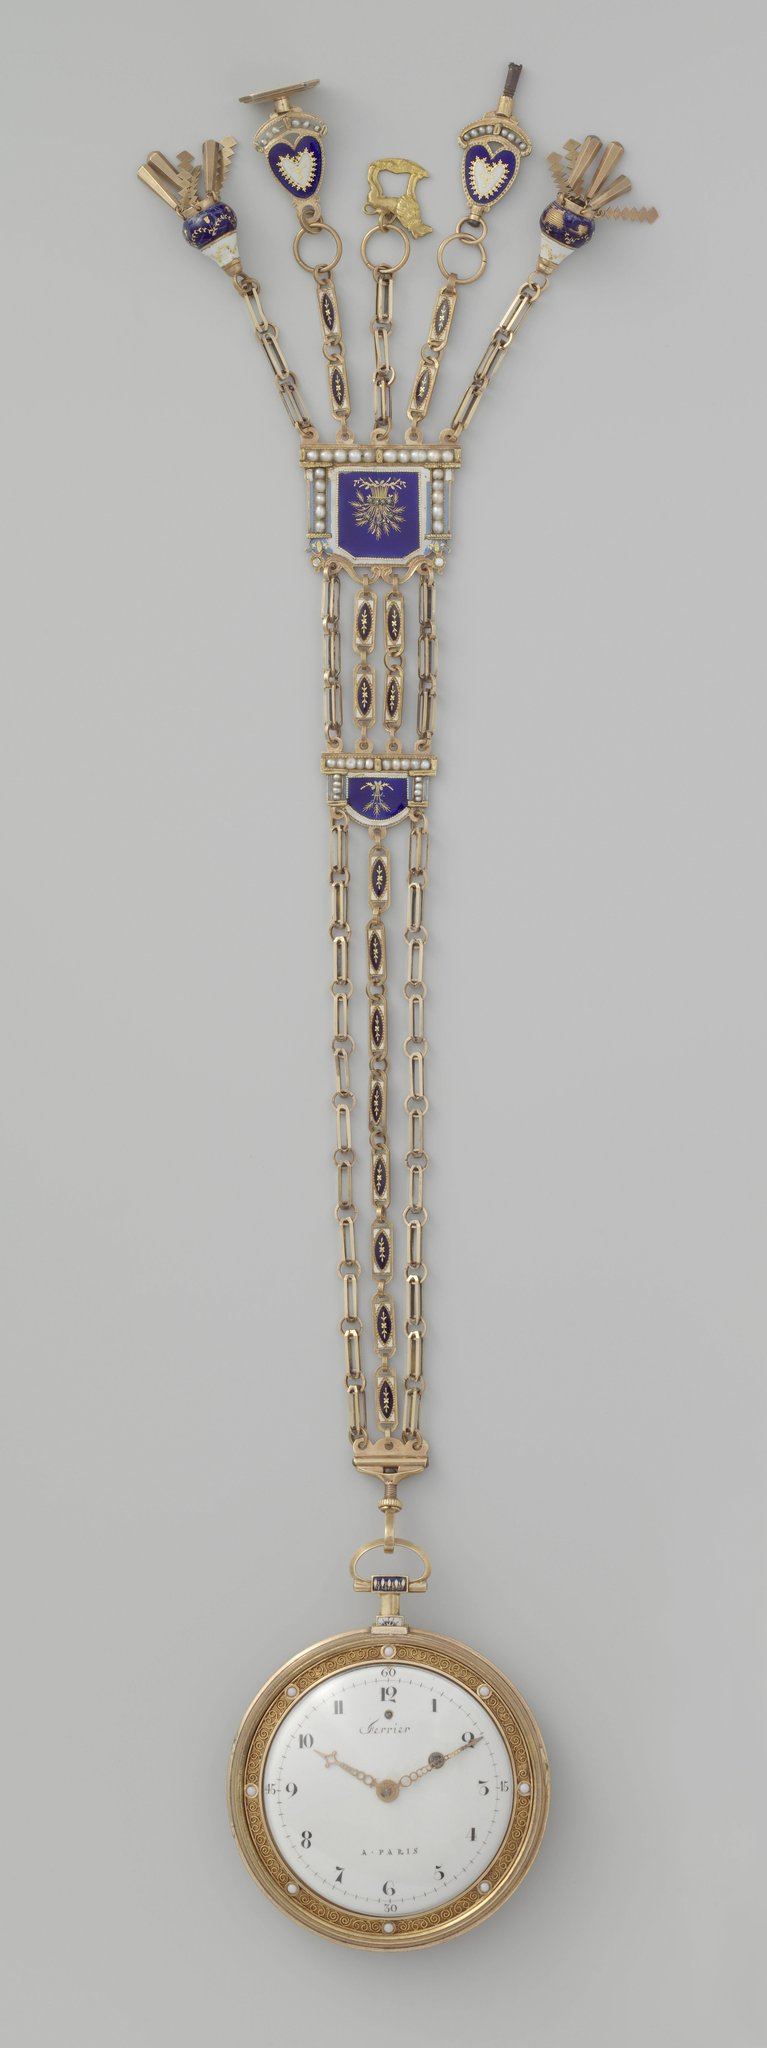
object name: chatelaine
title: Watch with an Allegory of Crowned Fame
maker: Anonymous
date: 1820-1840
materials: diamond, gold, pearl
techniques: enameling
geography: switzerland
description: Gouden horlogeketting samengesteld uit meerdere kettingen. Gedeeltelijk met blauwe en witte email versierd. Op de verbindingsstukken parels en diamantjes.